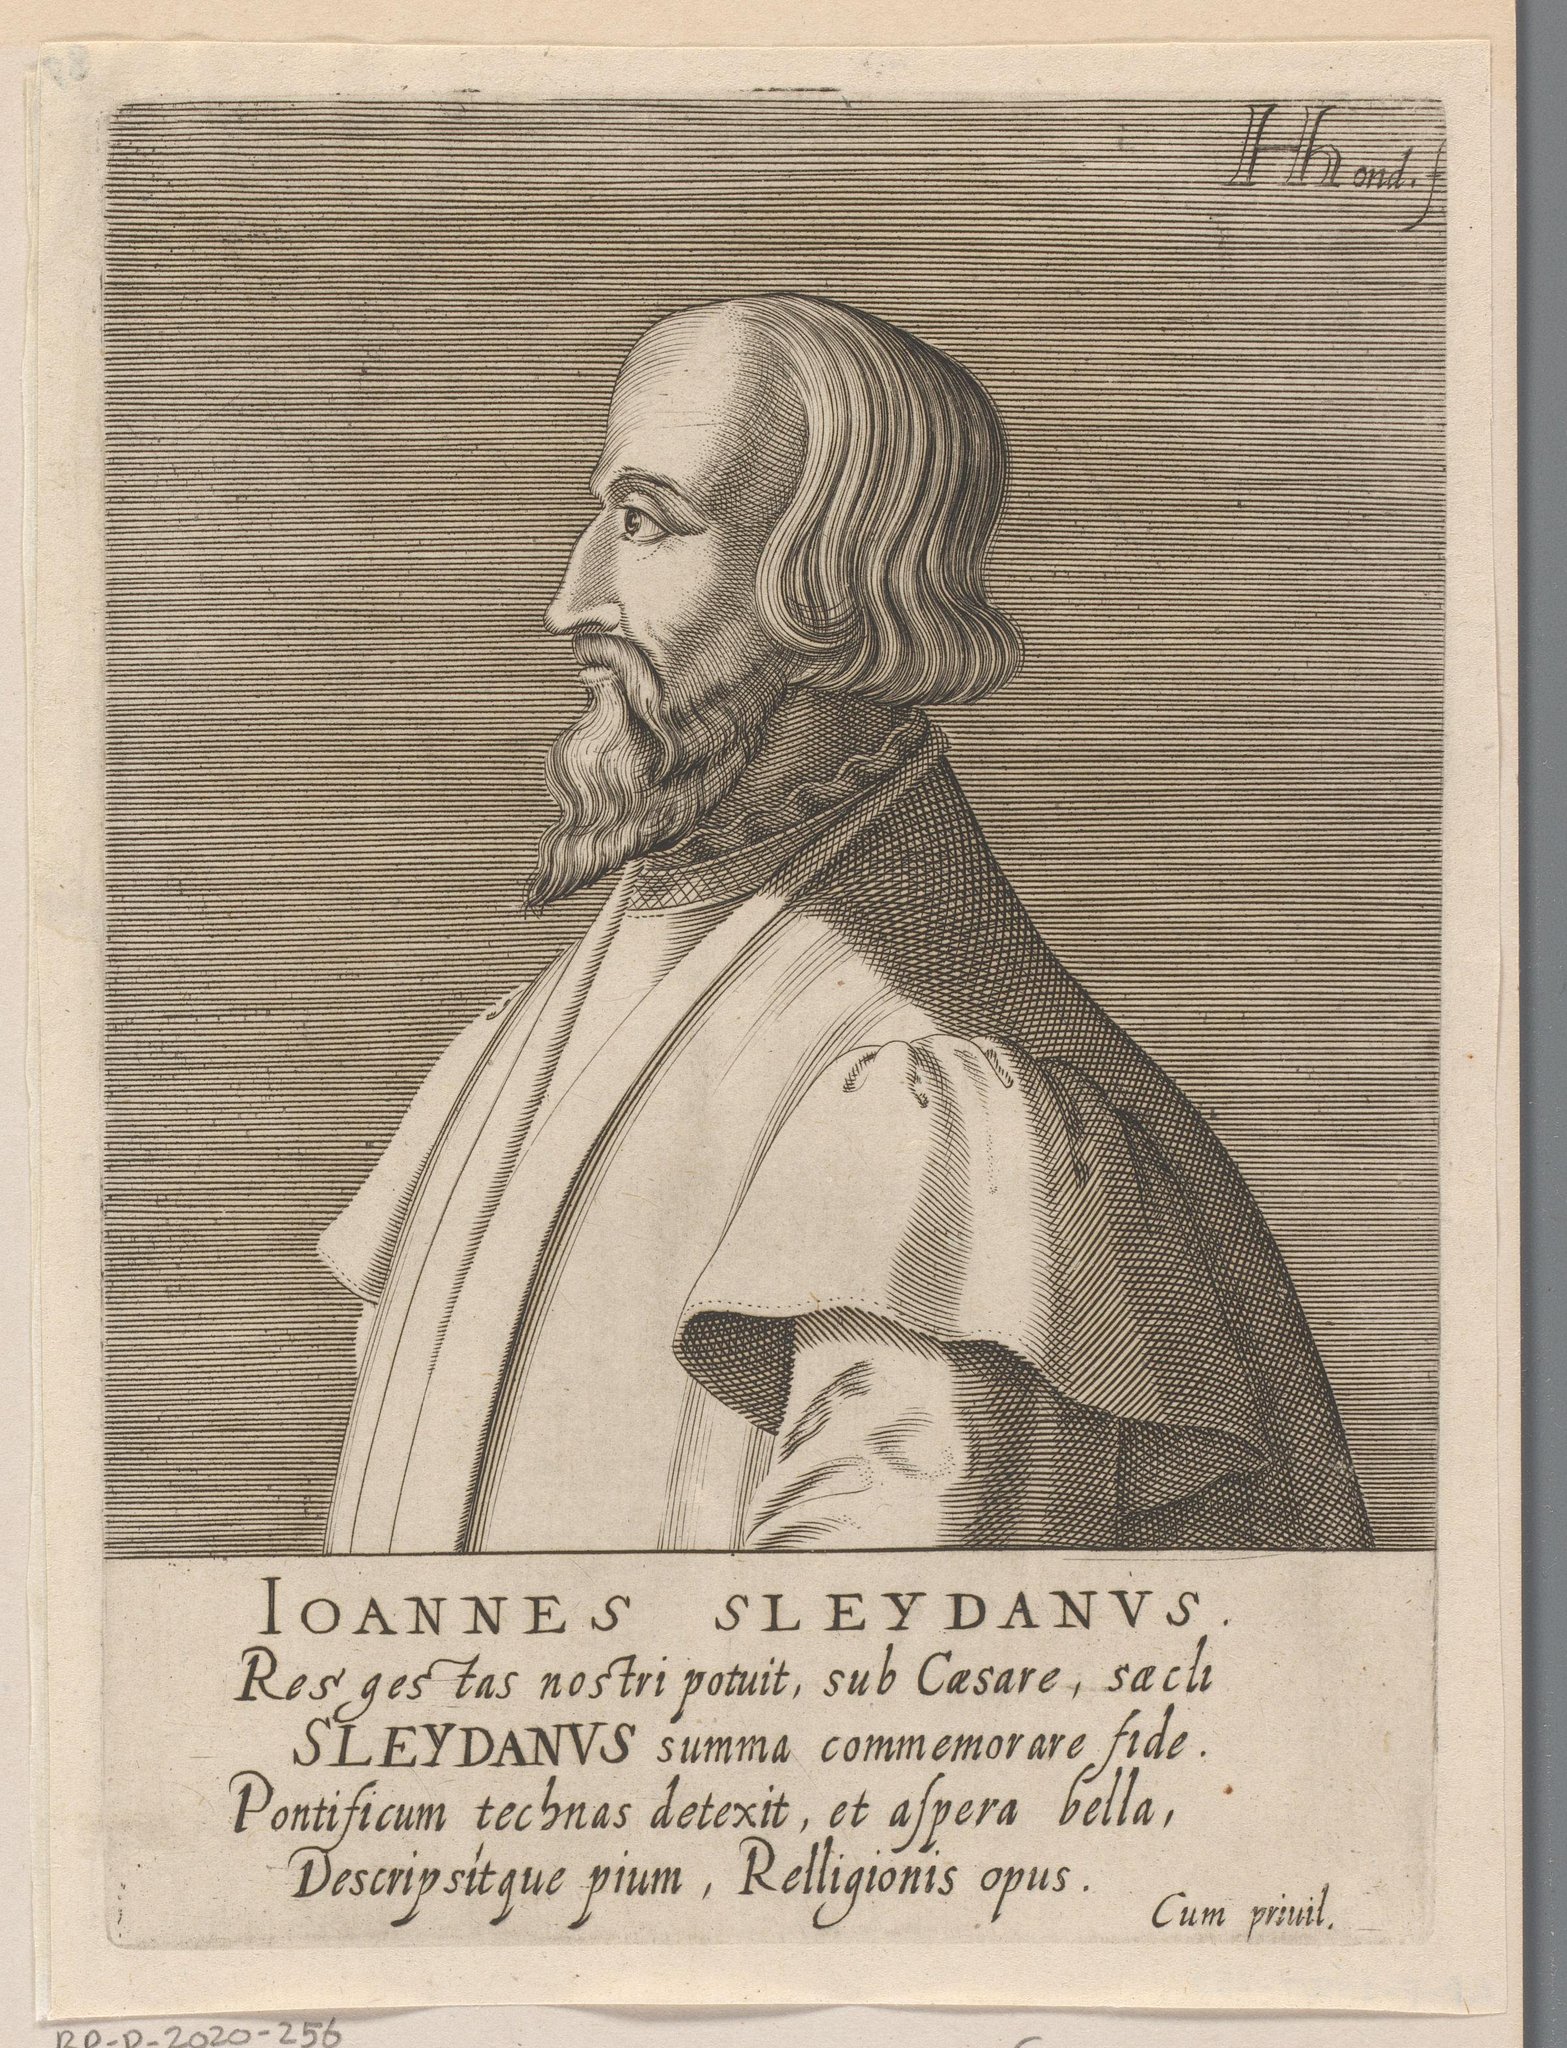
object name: print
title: Portret van Johannes Sleidanus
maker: hendrick hondius (i)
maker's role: draughtsman, print maker, publisher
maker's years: 1573-1650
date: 1602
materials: paper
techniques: engraving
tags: historical persons, diplomacy, diplomat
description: Prent gebruikt in: Verheiden, Jacob. Praestantium aliquot theologorum qui Rom. antichristum praecipuè oppugnarunt (...). Den Haag: Beuckel Corneliszoon Nieulandt,1602.